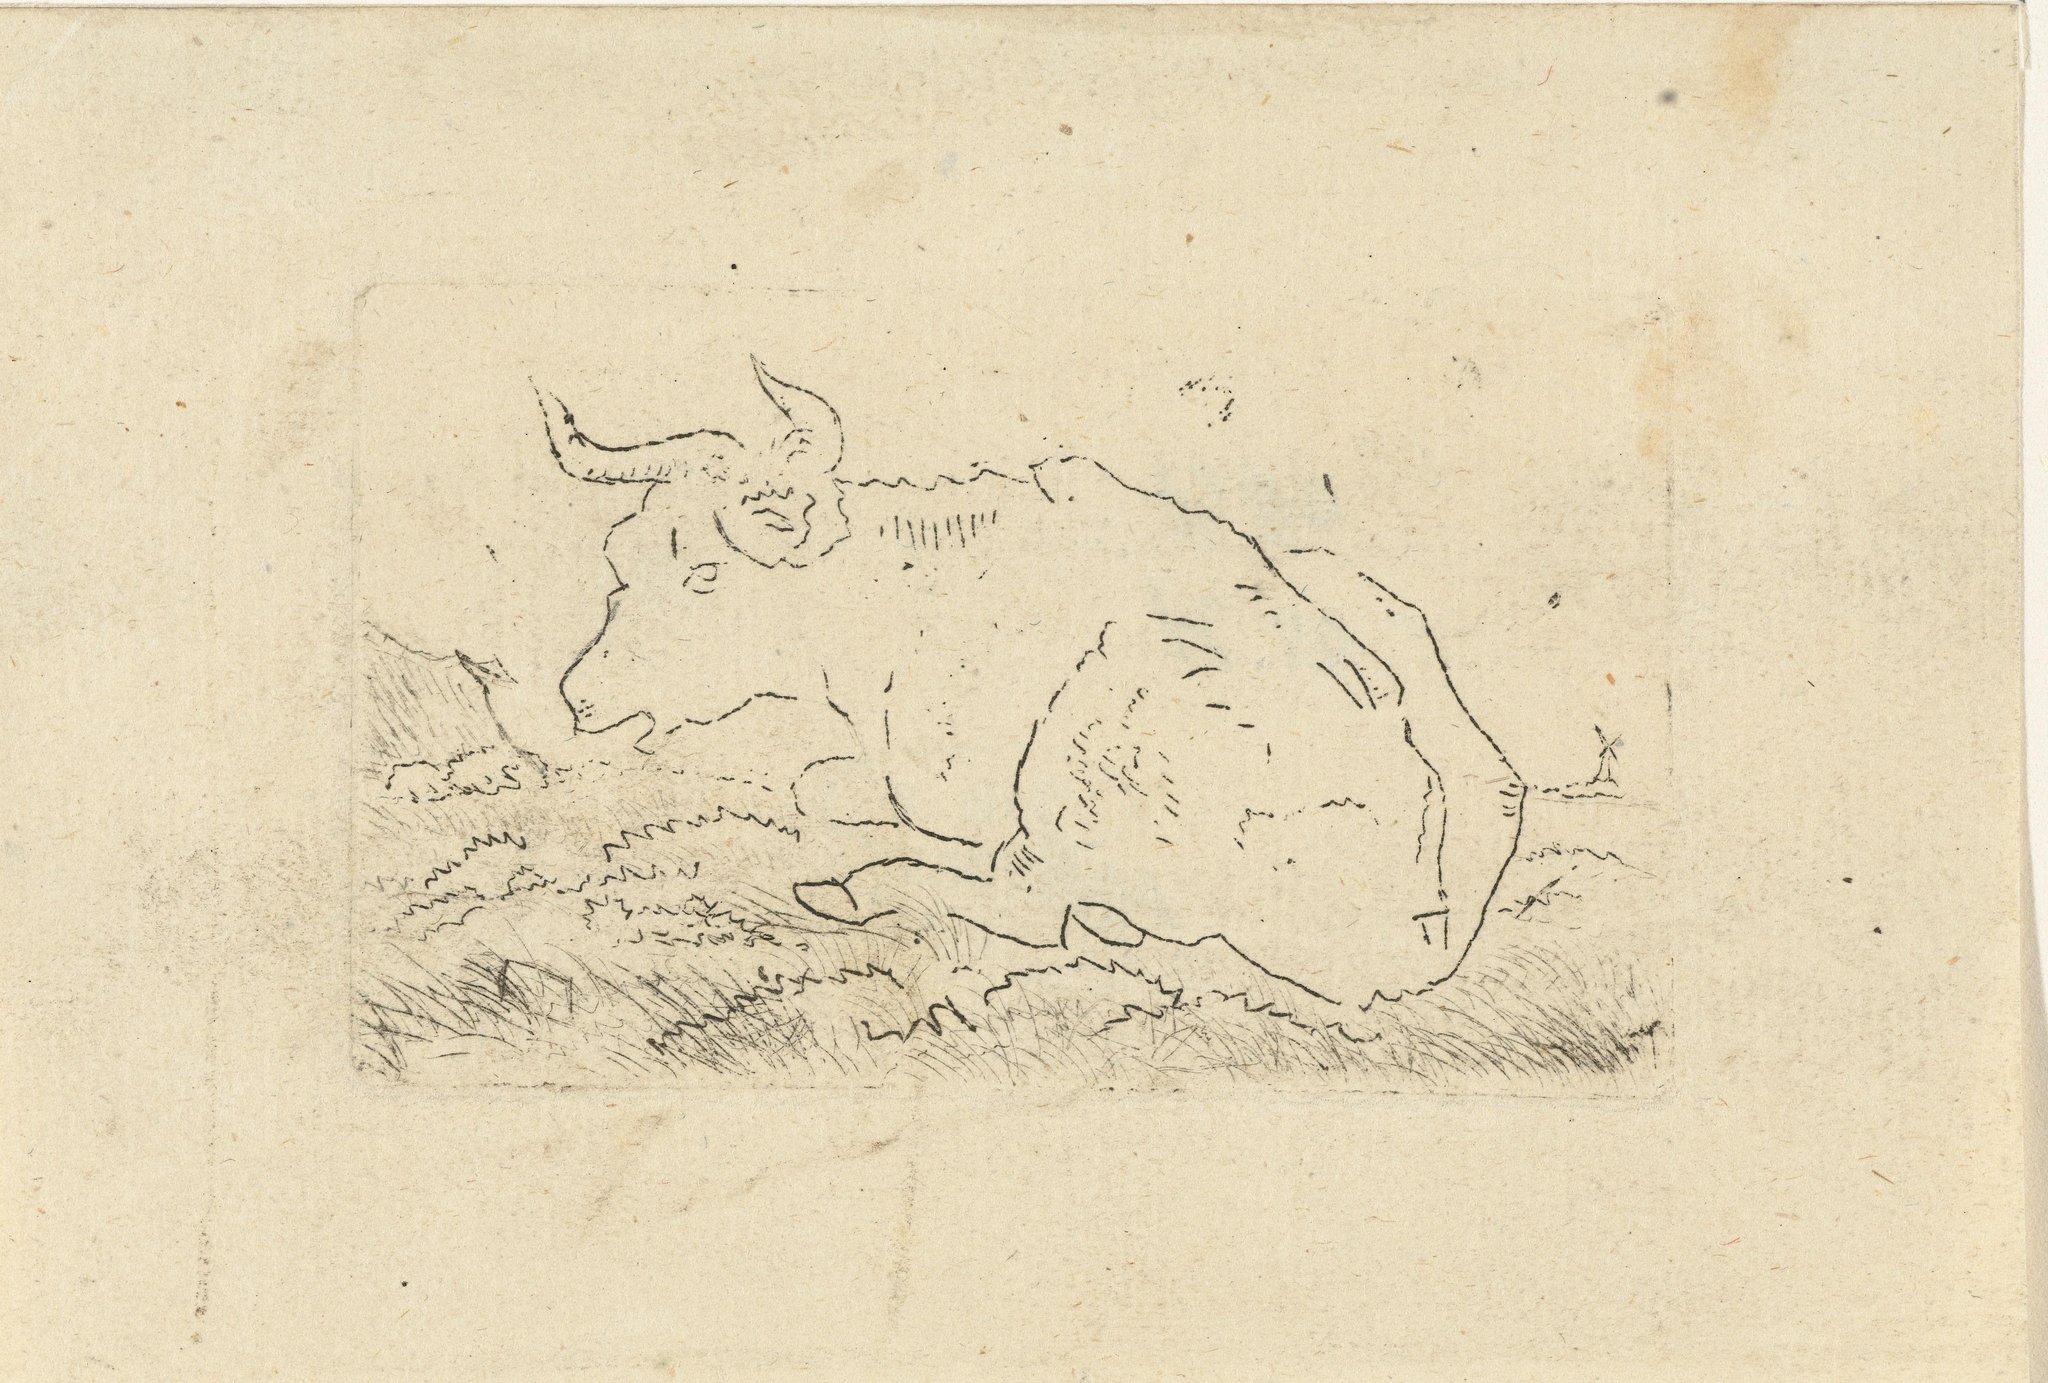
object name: print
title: Liggende koe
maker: ernst willem jan bagelaar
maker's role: draughtsman, print maker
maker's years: 1775-1837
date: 1798-1837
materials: paper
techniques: etching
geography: netherlands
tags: cow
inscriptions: collector's mark: Lugt 2228